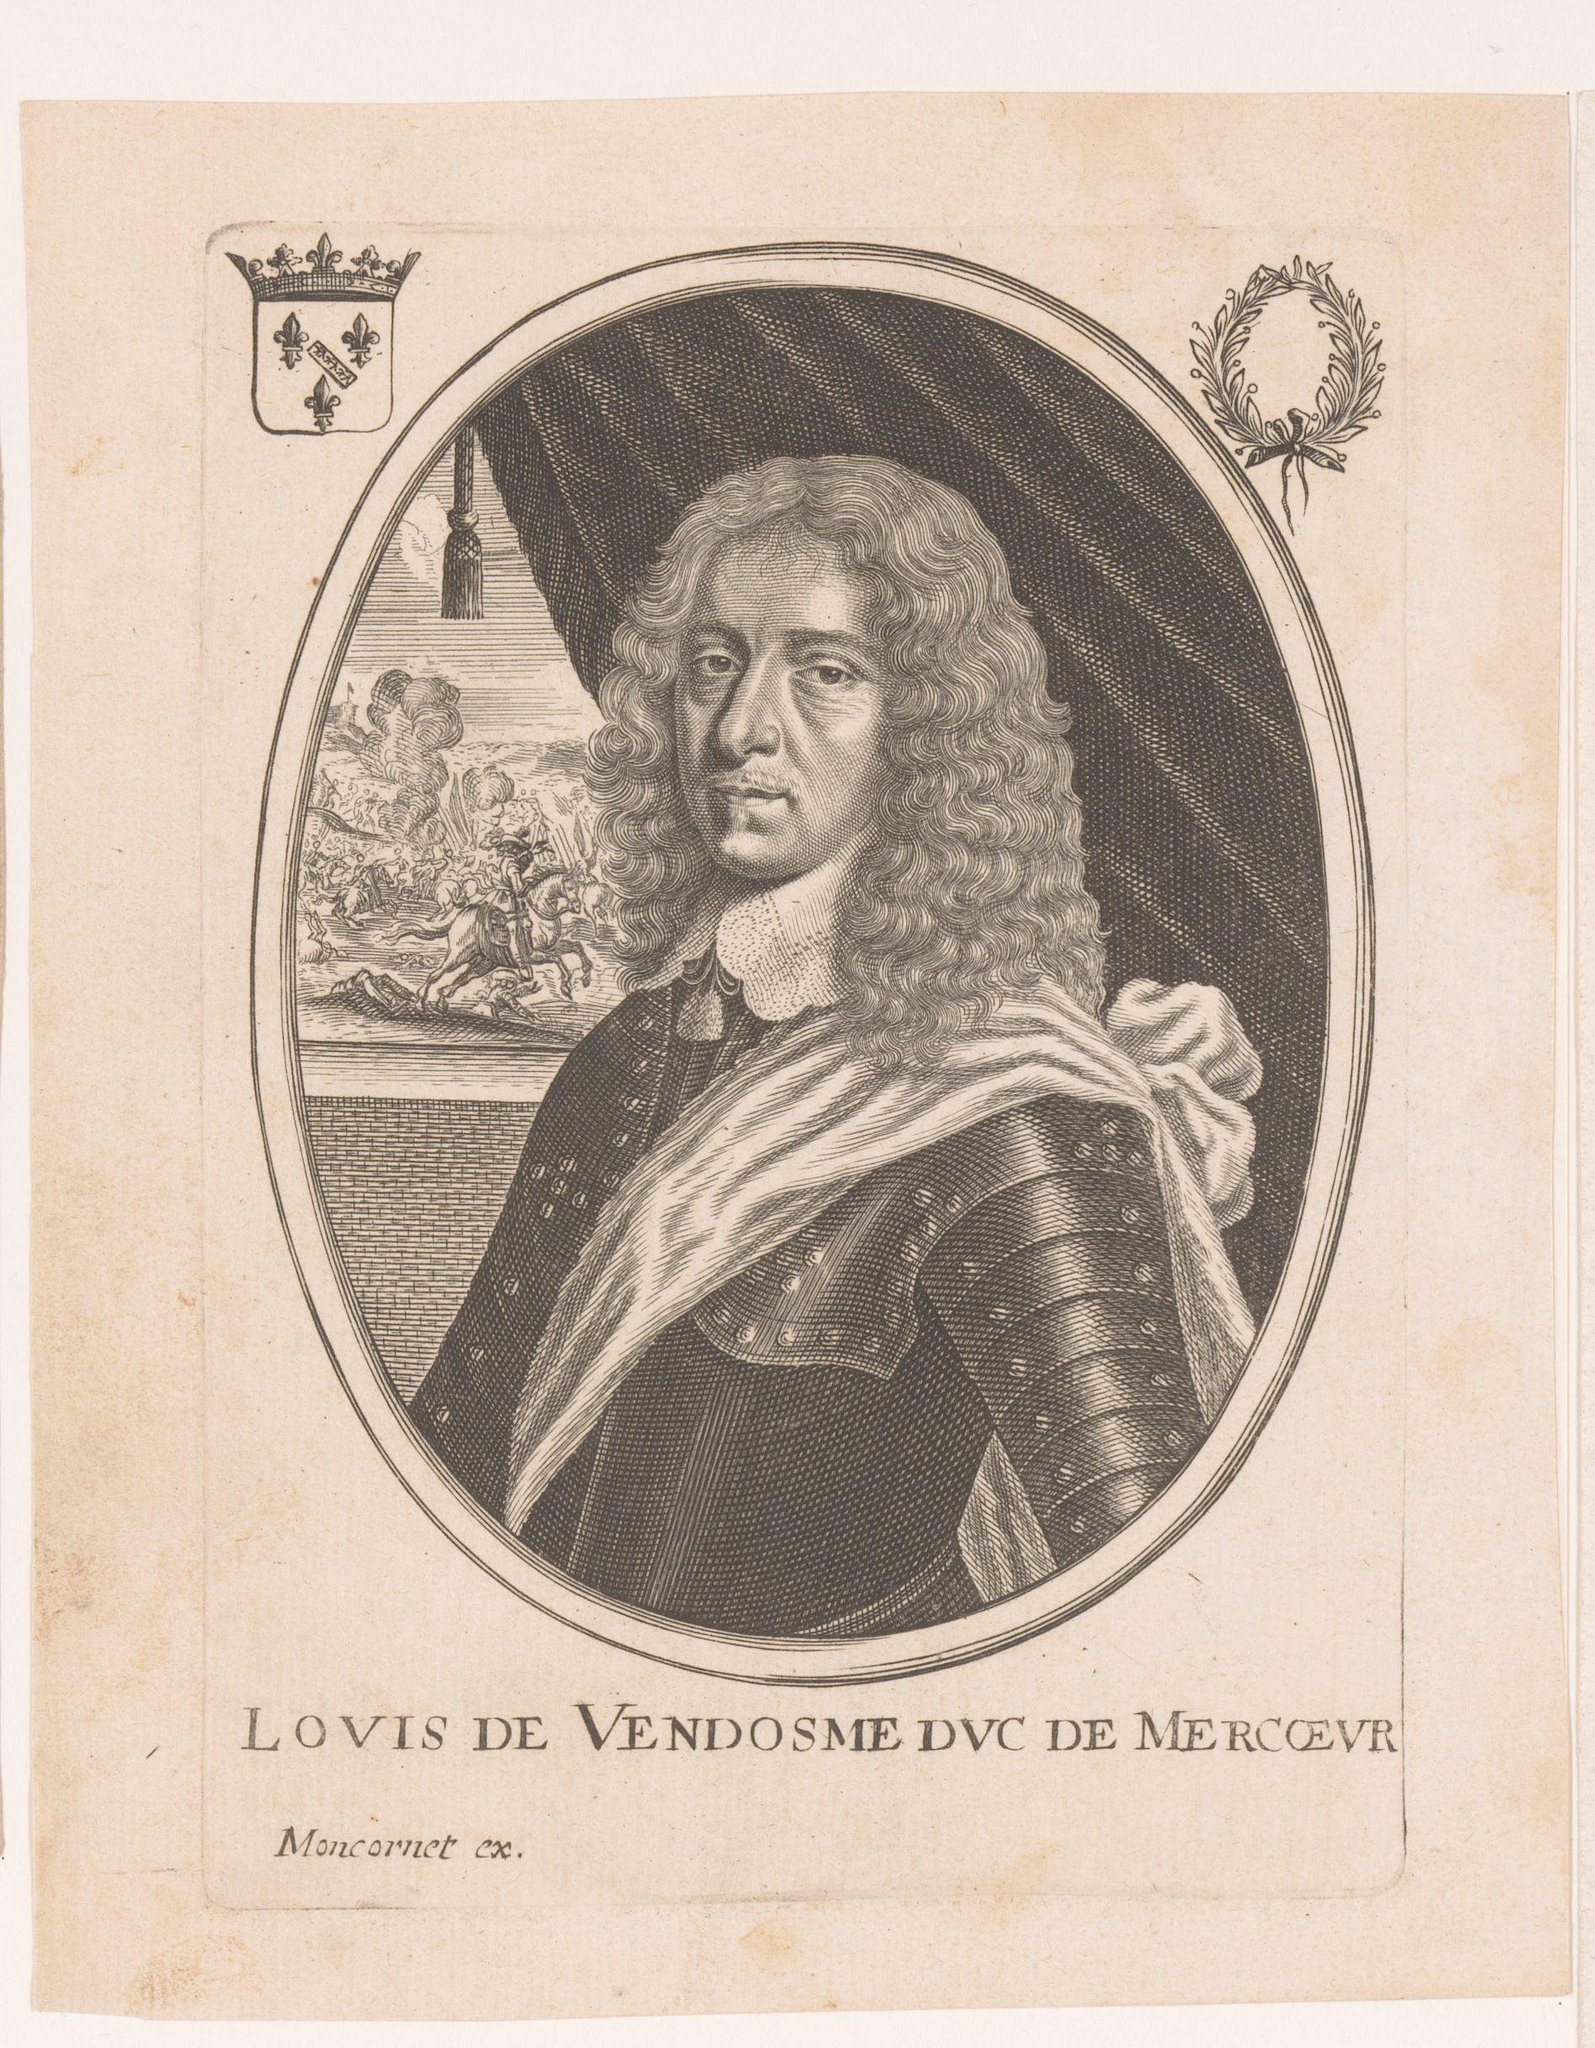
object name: print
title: Portret van Lodewijk II van Vendôme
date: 1647-1668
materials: paper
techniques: engraving, etching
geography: paris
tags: paris, historical persons, armorial bearing, heraldry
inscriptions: collector's mark: Lugt 2228